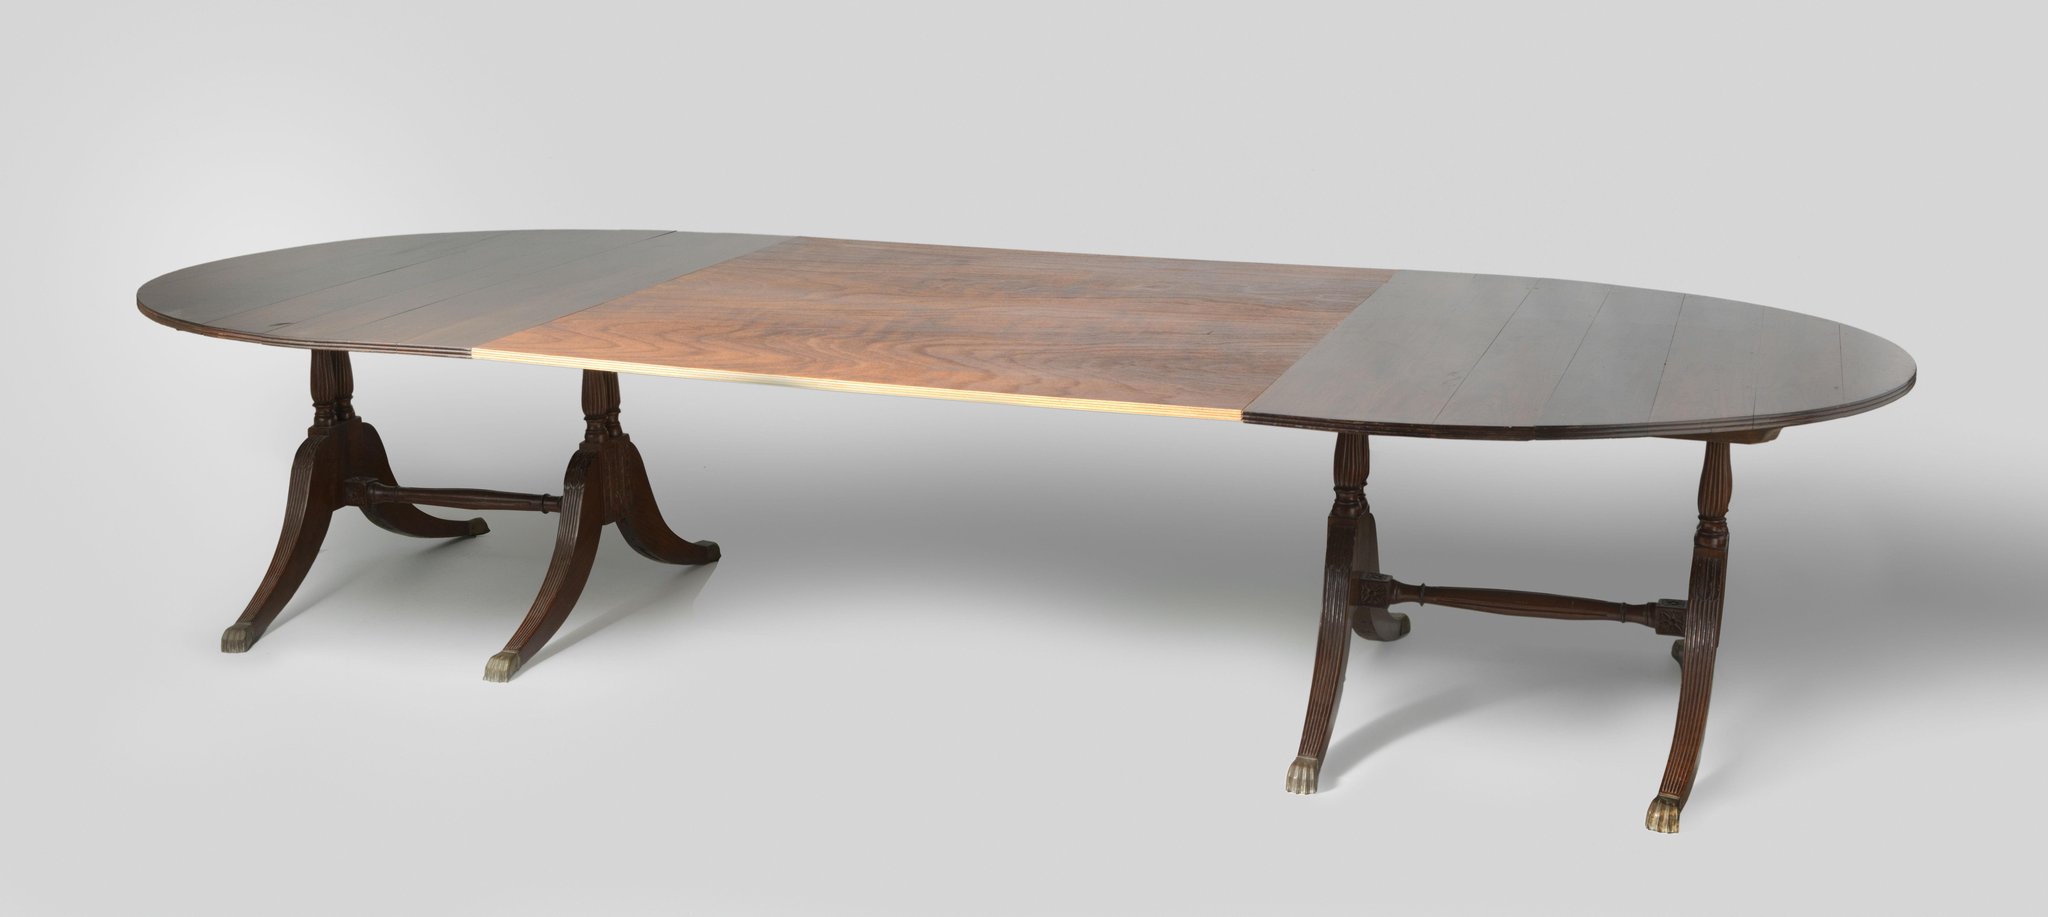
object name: furniture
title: Halve tafel met ovaal blad en schraagvormige poten die eindigen in klauwen van koper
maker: Anonymous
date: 1800-1815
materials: copper, wood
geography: indonesia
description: Grote tafel van ijzerhout met een ovaal blad dat uit twee delen bestaat. De poten bestaan uit vier schraagvormige steunen, eindigend in koperen klauwen; ieder der steunen draagt twee gecanneleerde korte zuilen, waar het blad op steunt. De steunen worden paarsgewijs verbonden door een gelede zuilvormige dwarsregel, geplaatst tussen huizen versierd met rozetten.